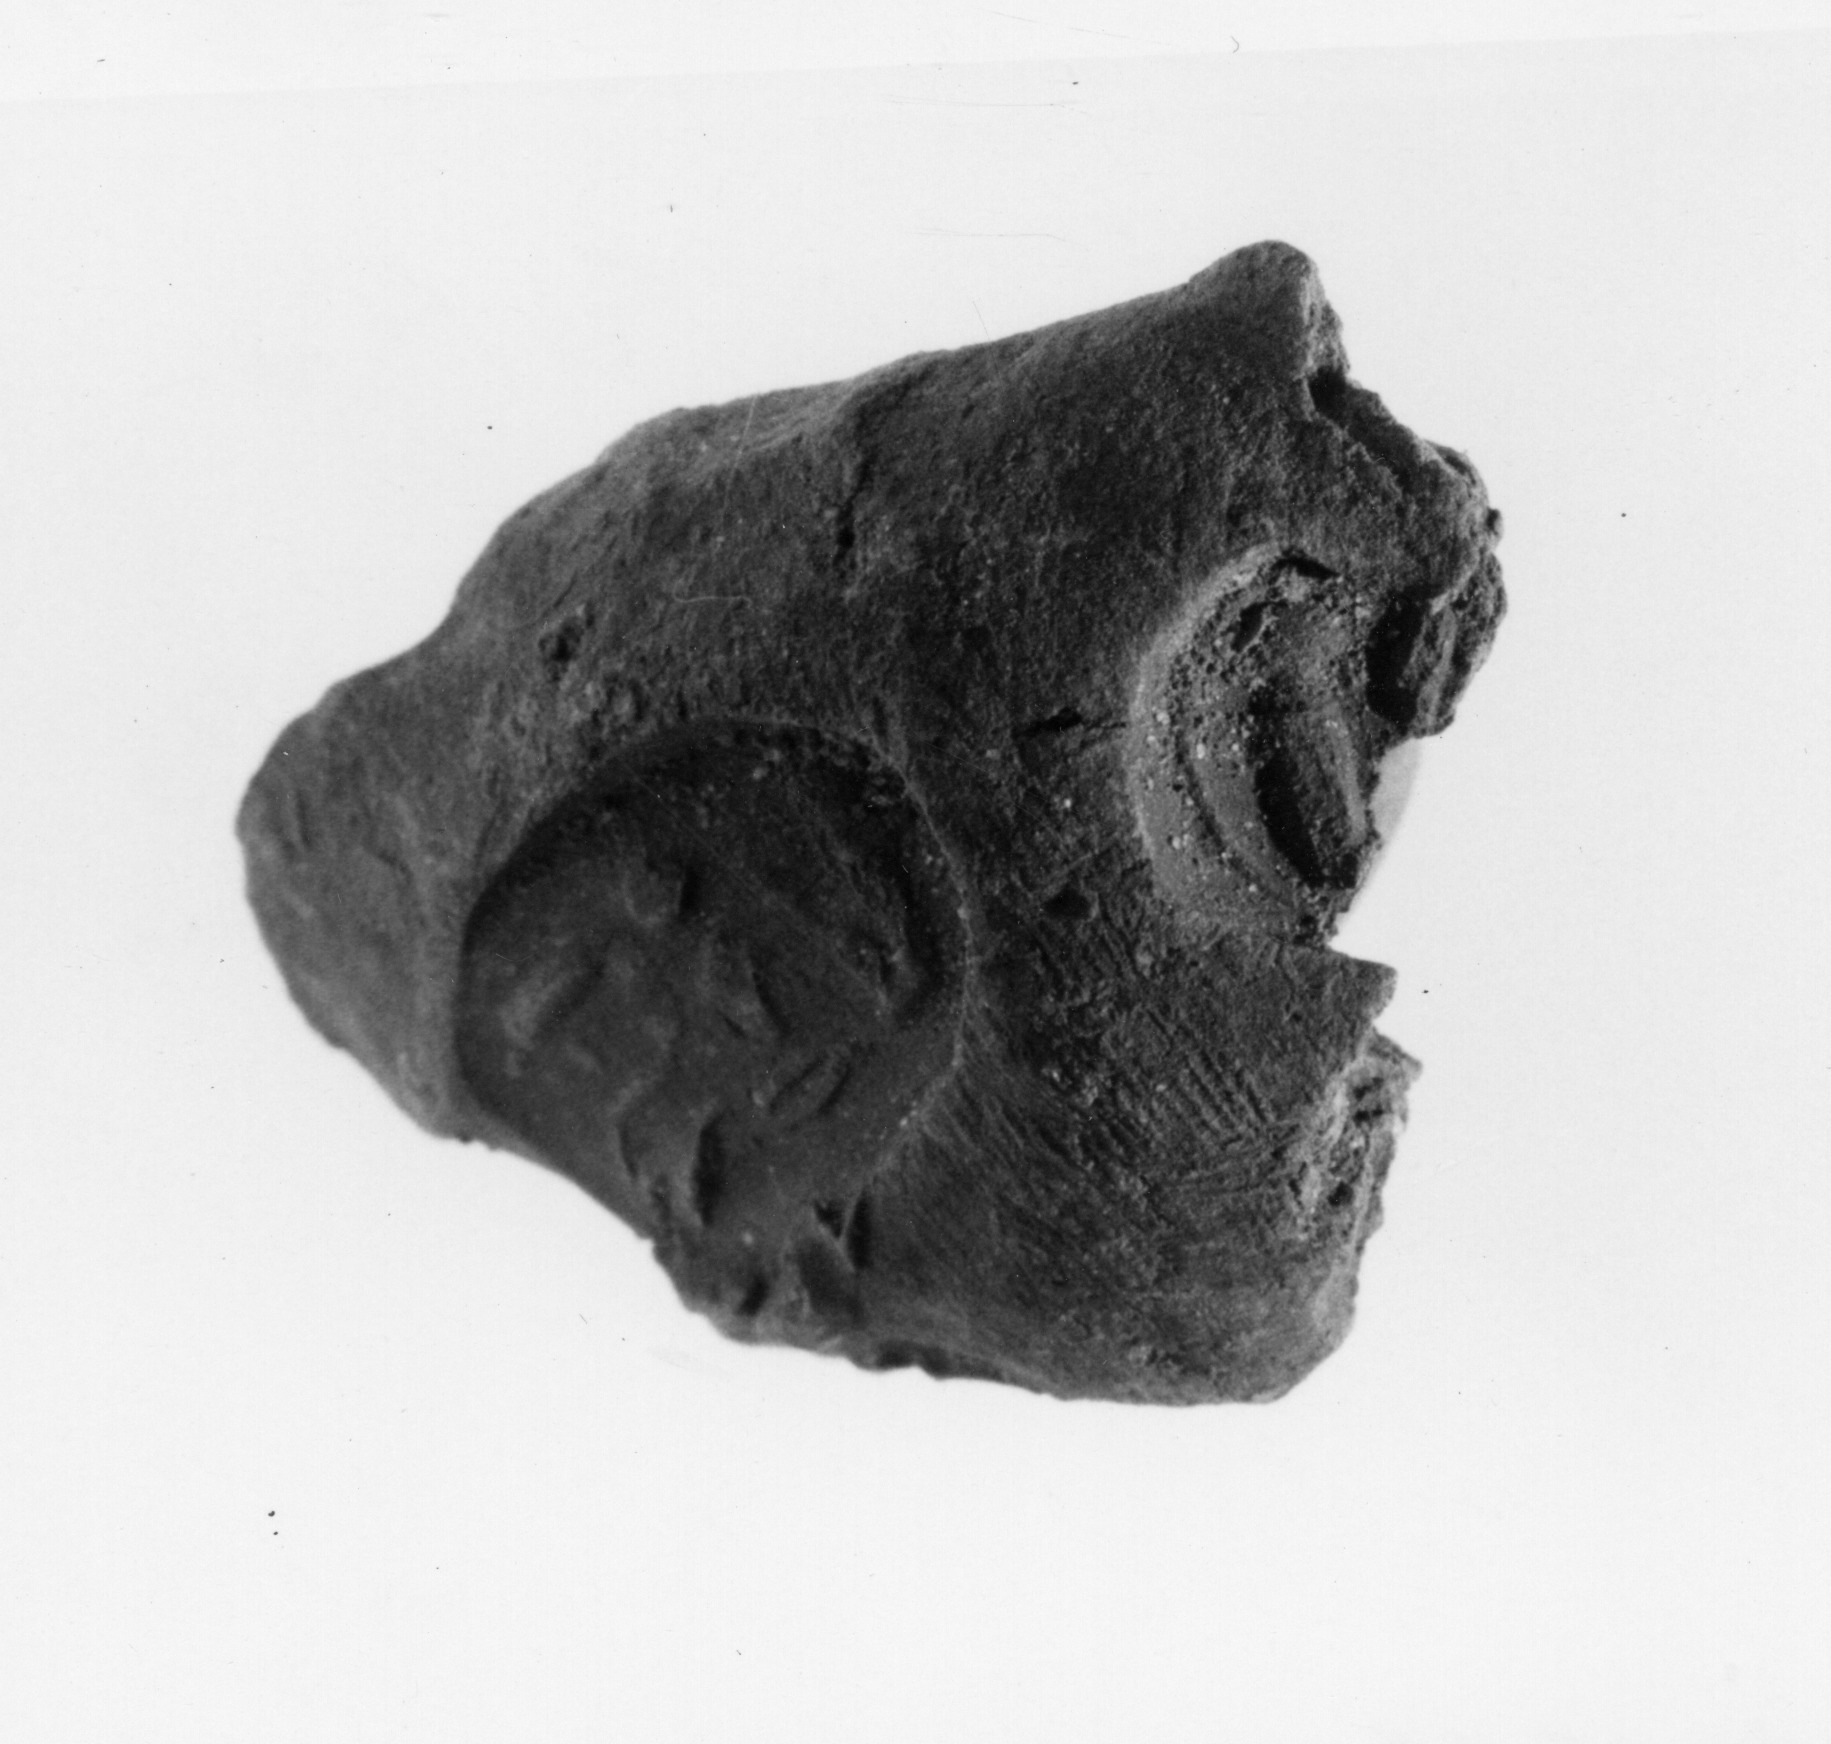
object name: sealing, nebmaatre, amenhotep iii,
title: Document Sealing With Multiple Seal Impressions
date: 1390-1352 BCE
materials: mud